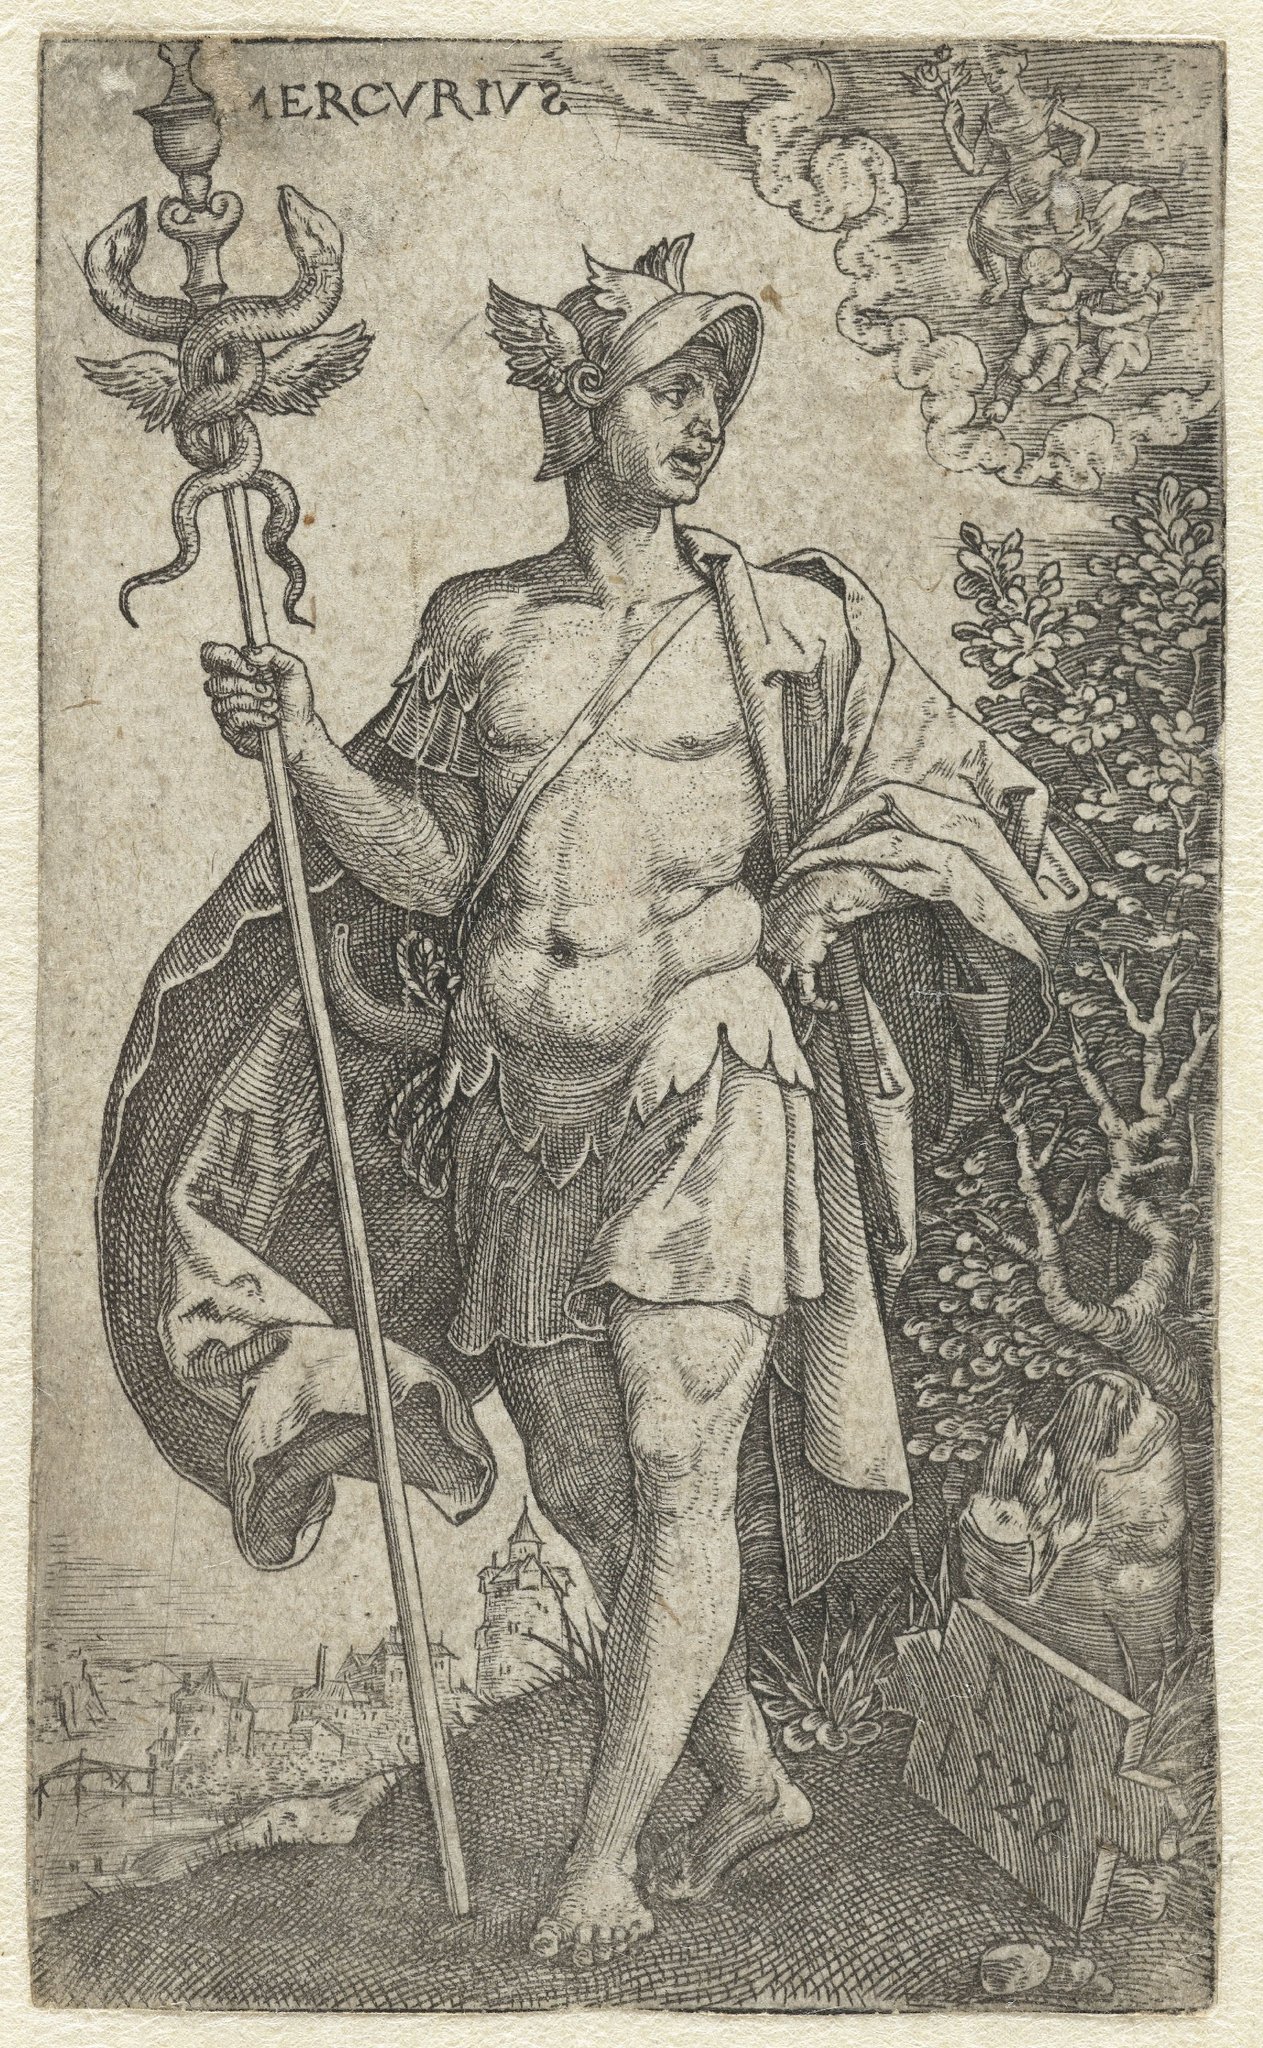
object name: print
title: Mercurius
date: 1528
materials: paper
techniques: engraving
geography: germany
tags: (story of) mercury (hermes)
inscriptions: collector's mark: ‘Hinloopen’ Lugt 11, collector's mark: Lugt 2228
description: Mercurius, een helm met vleugels op het hoofd en een staf met twee slangen in de rechterhand. In de lucht de twee sterrenbeelden Maagd en Tweelingen.